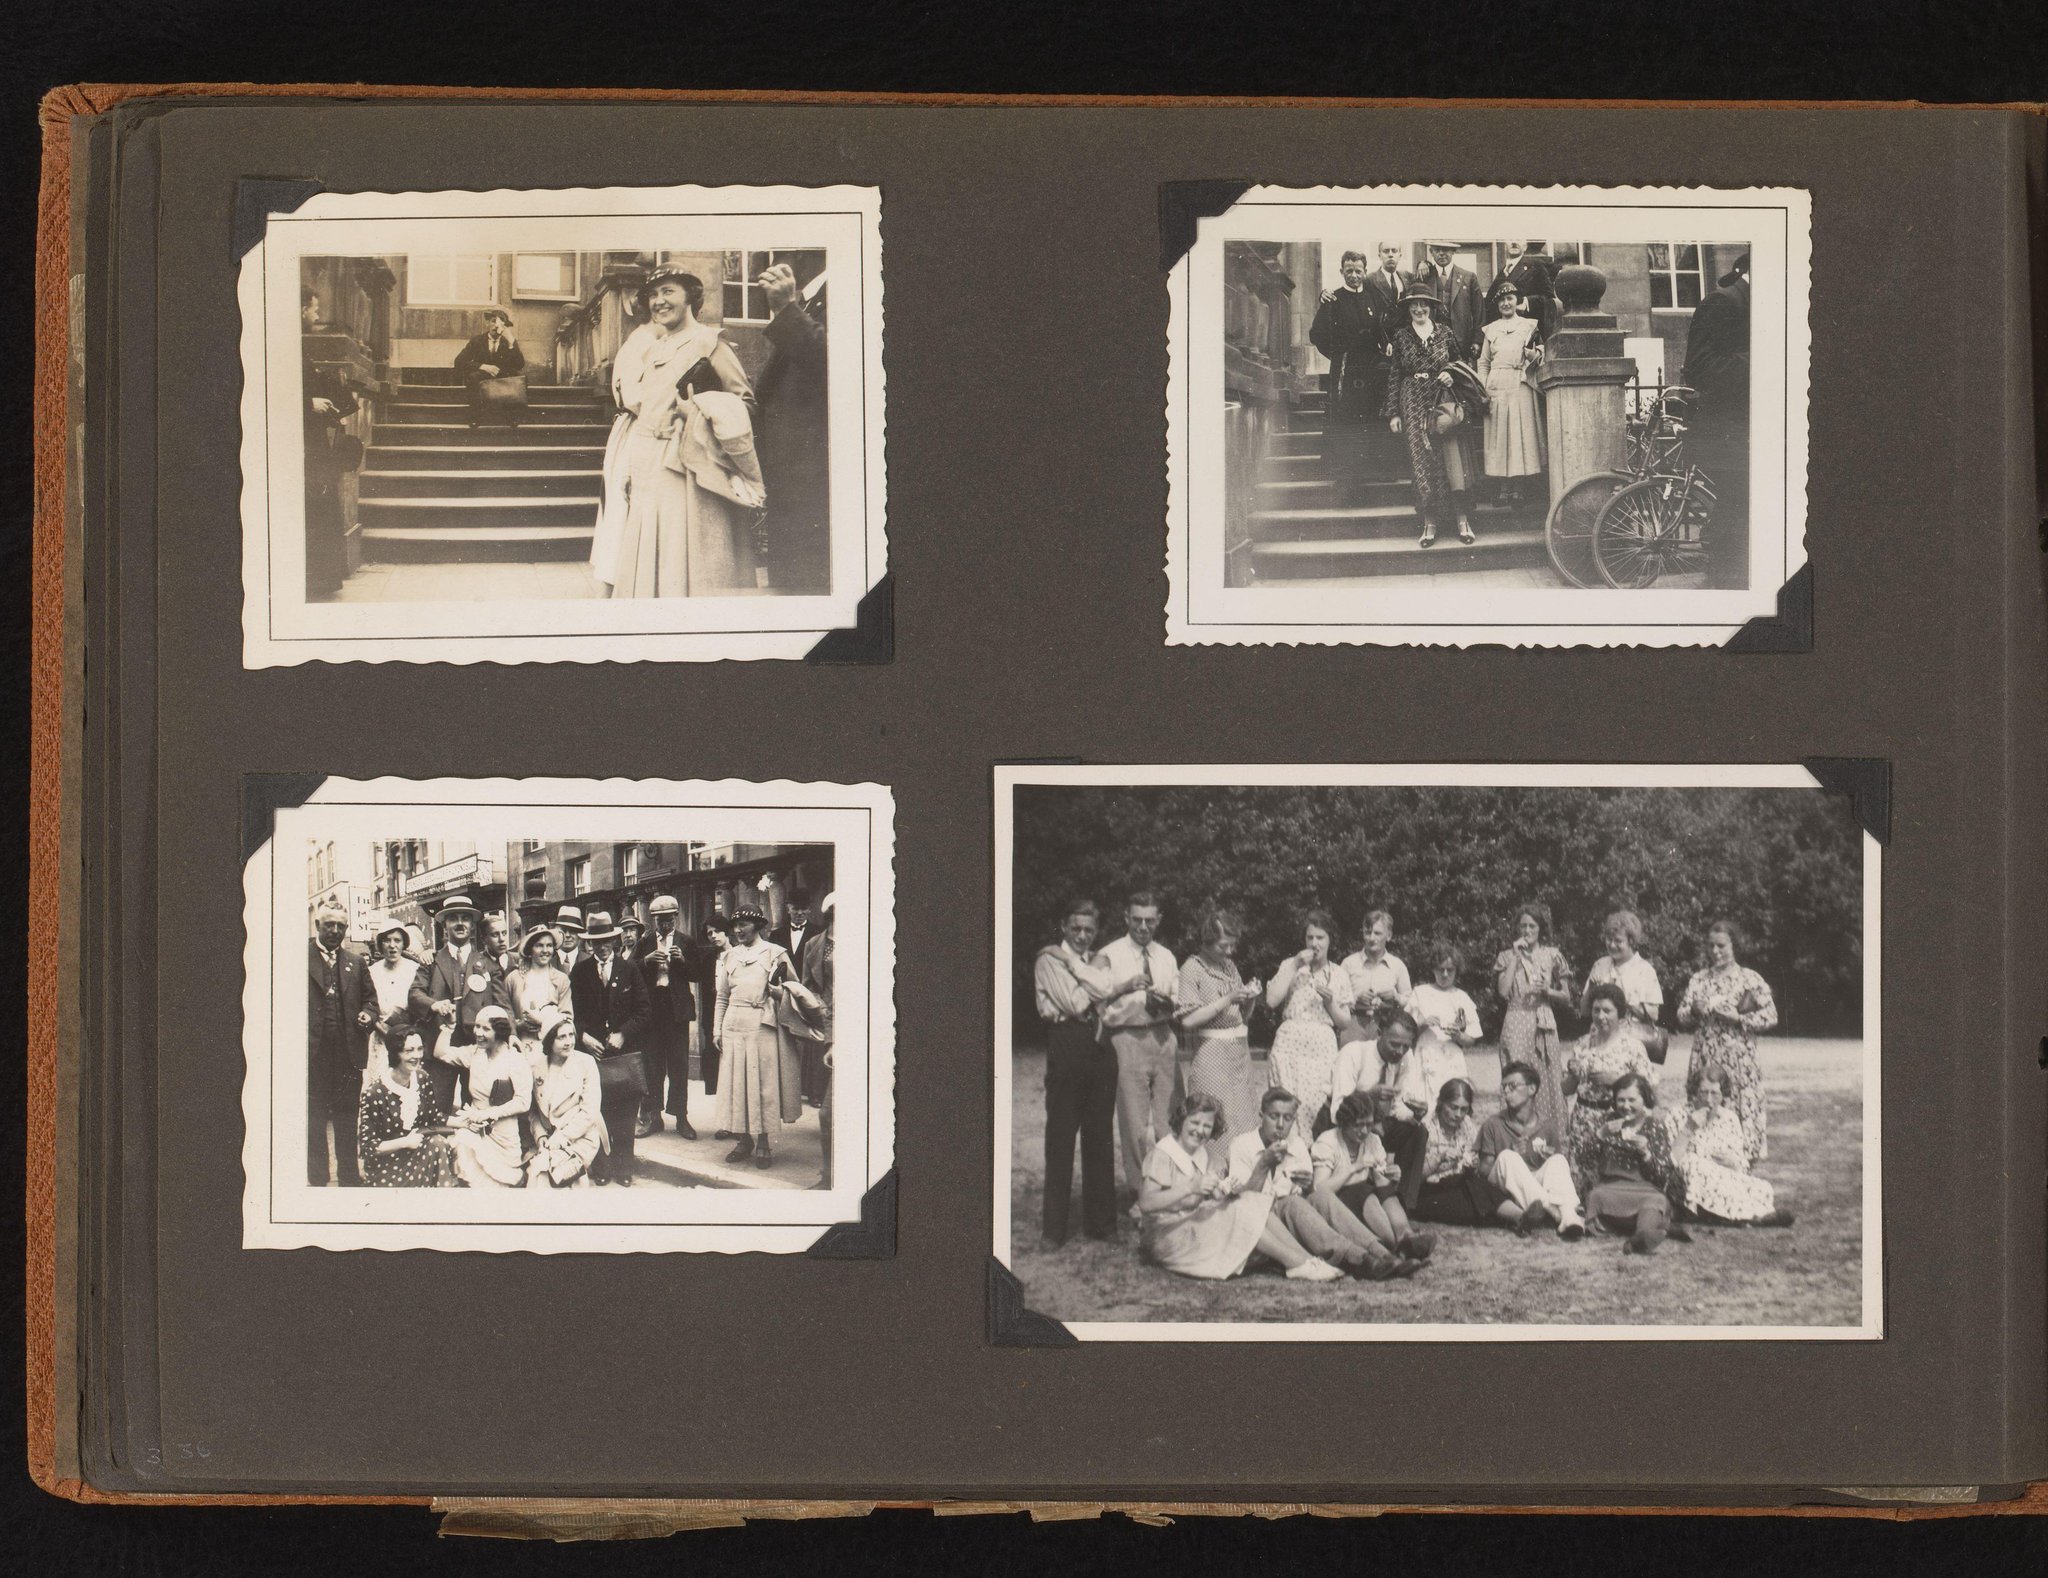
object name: photograph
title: Esperanto zomerkamp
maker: Anonymous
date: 1908-1934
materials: paper, photographic support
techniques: gelatin silver print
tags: esperanto, open-air recreation, anonymous historical persons portrayed in a group, in a group-portrait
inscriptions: inscription: ‘5-8-'34’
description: Albumblad met vier foto's van een groep mensen op een Esperanto bijeenkomst, zomerfeest of zomerkamp, augustus 1934, en van kleinere groepen in een stad. Onderdeel van het Esperanto album uit ca. 1933-1936.